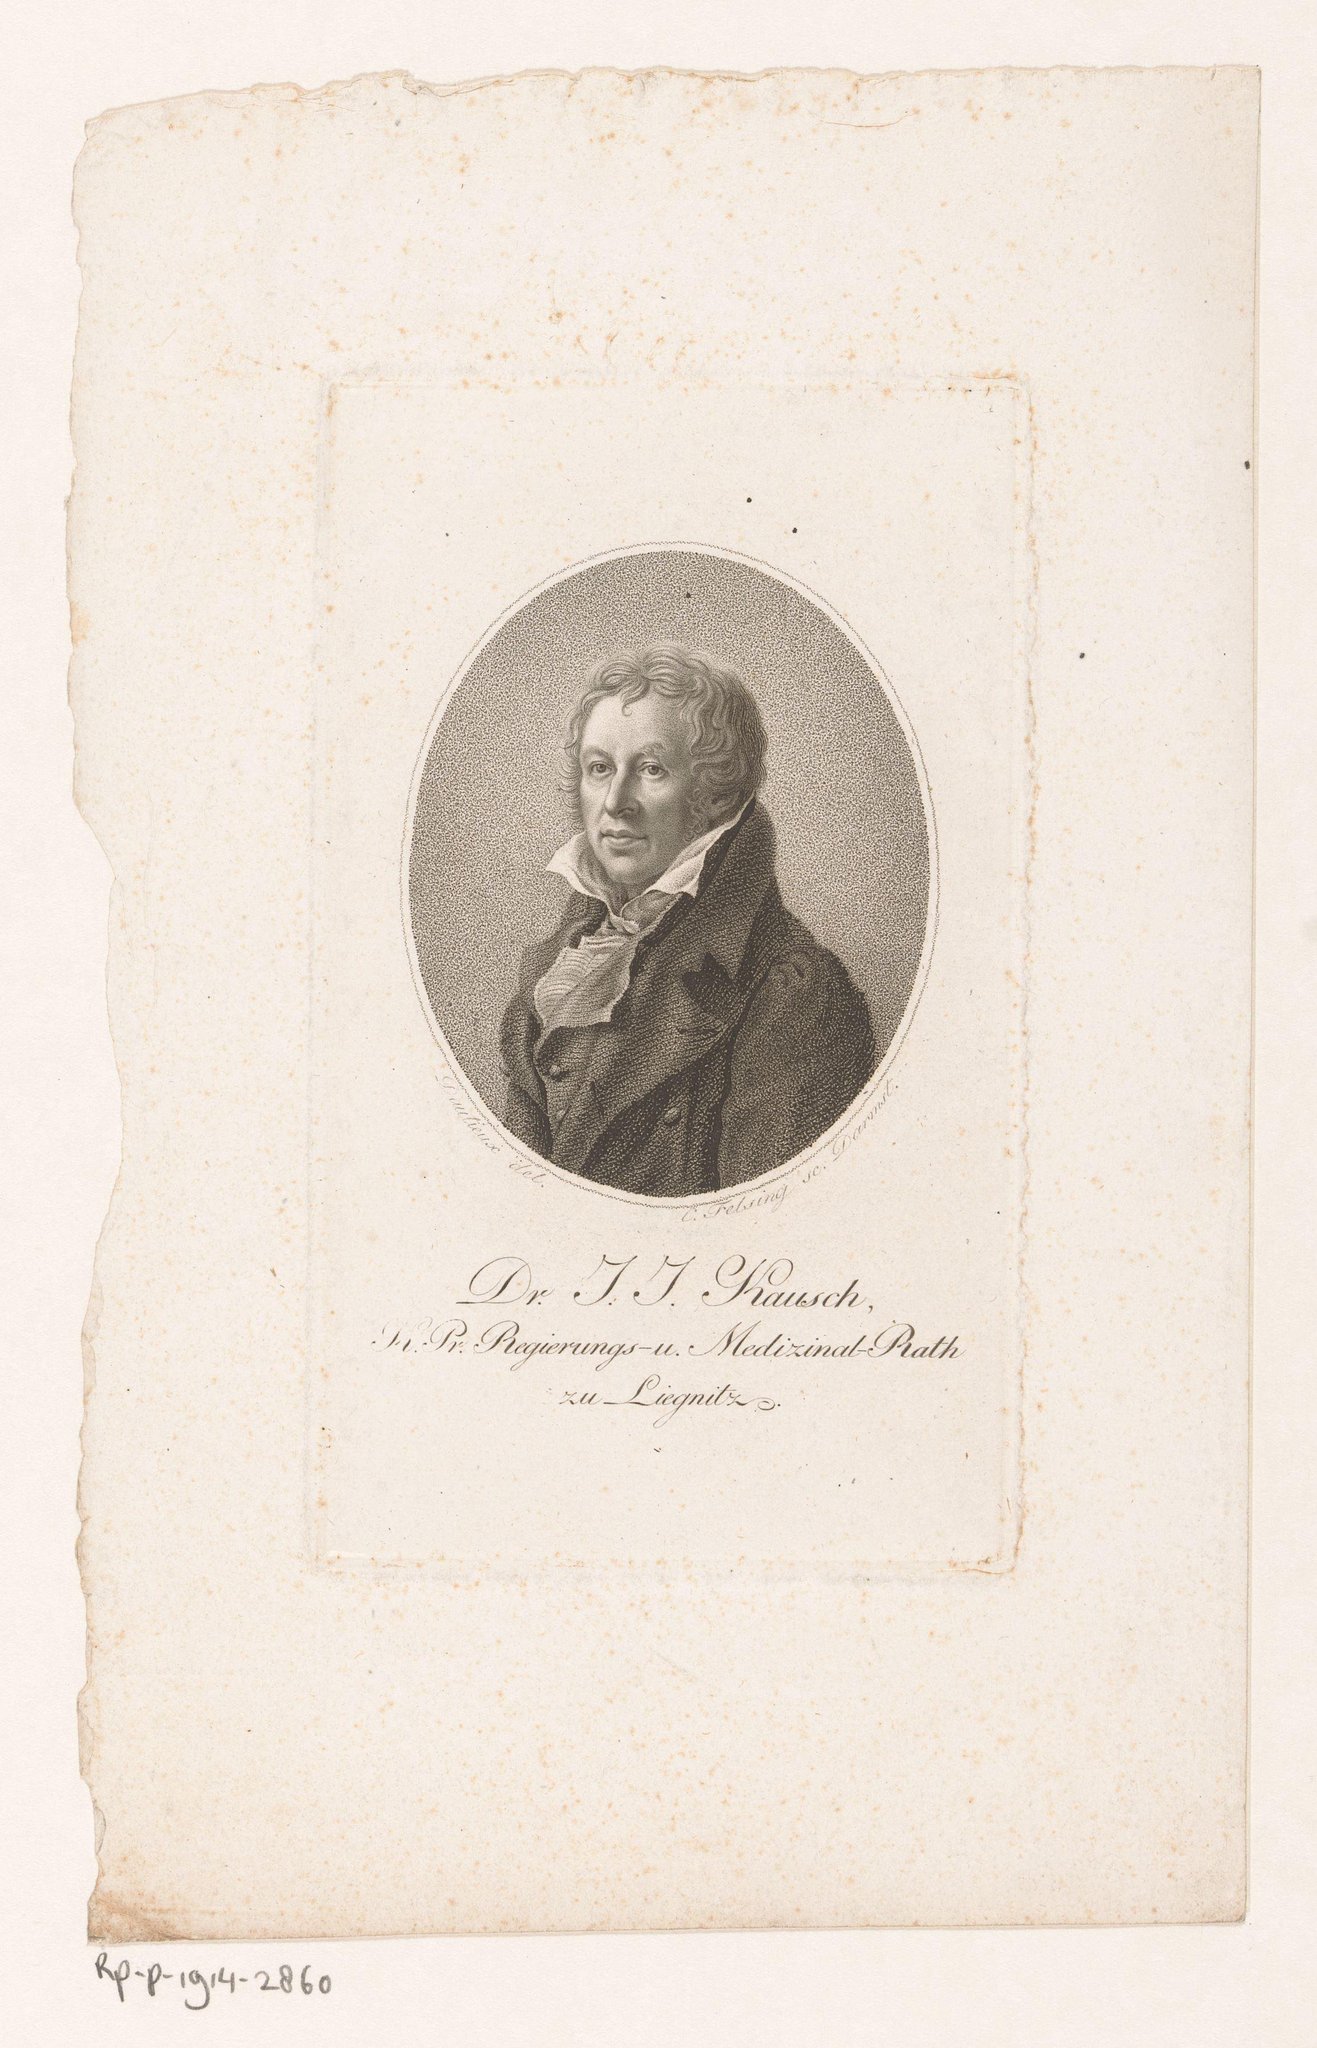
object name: print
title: Portret van Johann Joseph Kausch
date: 1776-1819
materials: paper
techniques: engraving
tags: historical persons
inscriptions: collector's mark: Lugt 2228